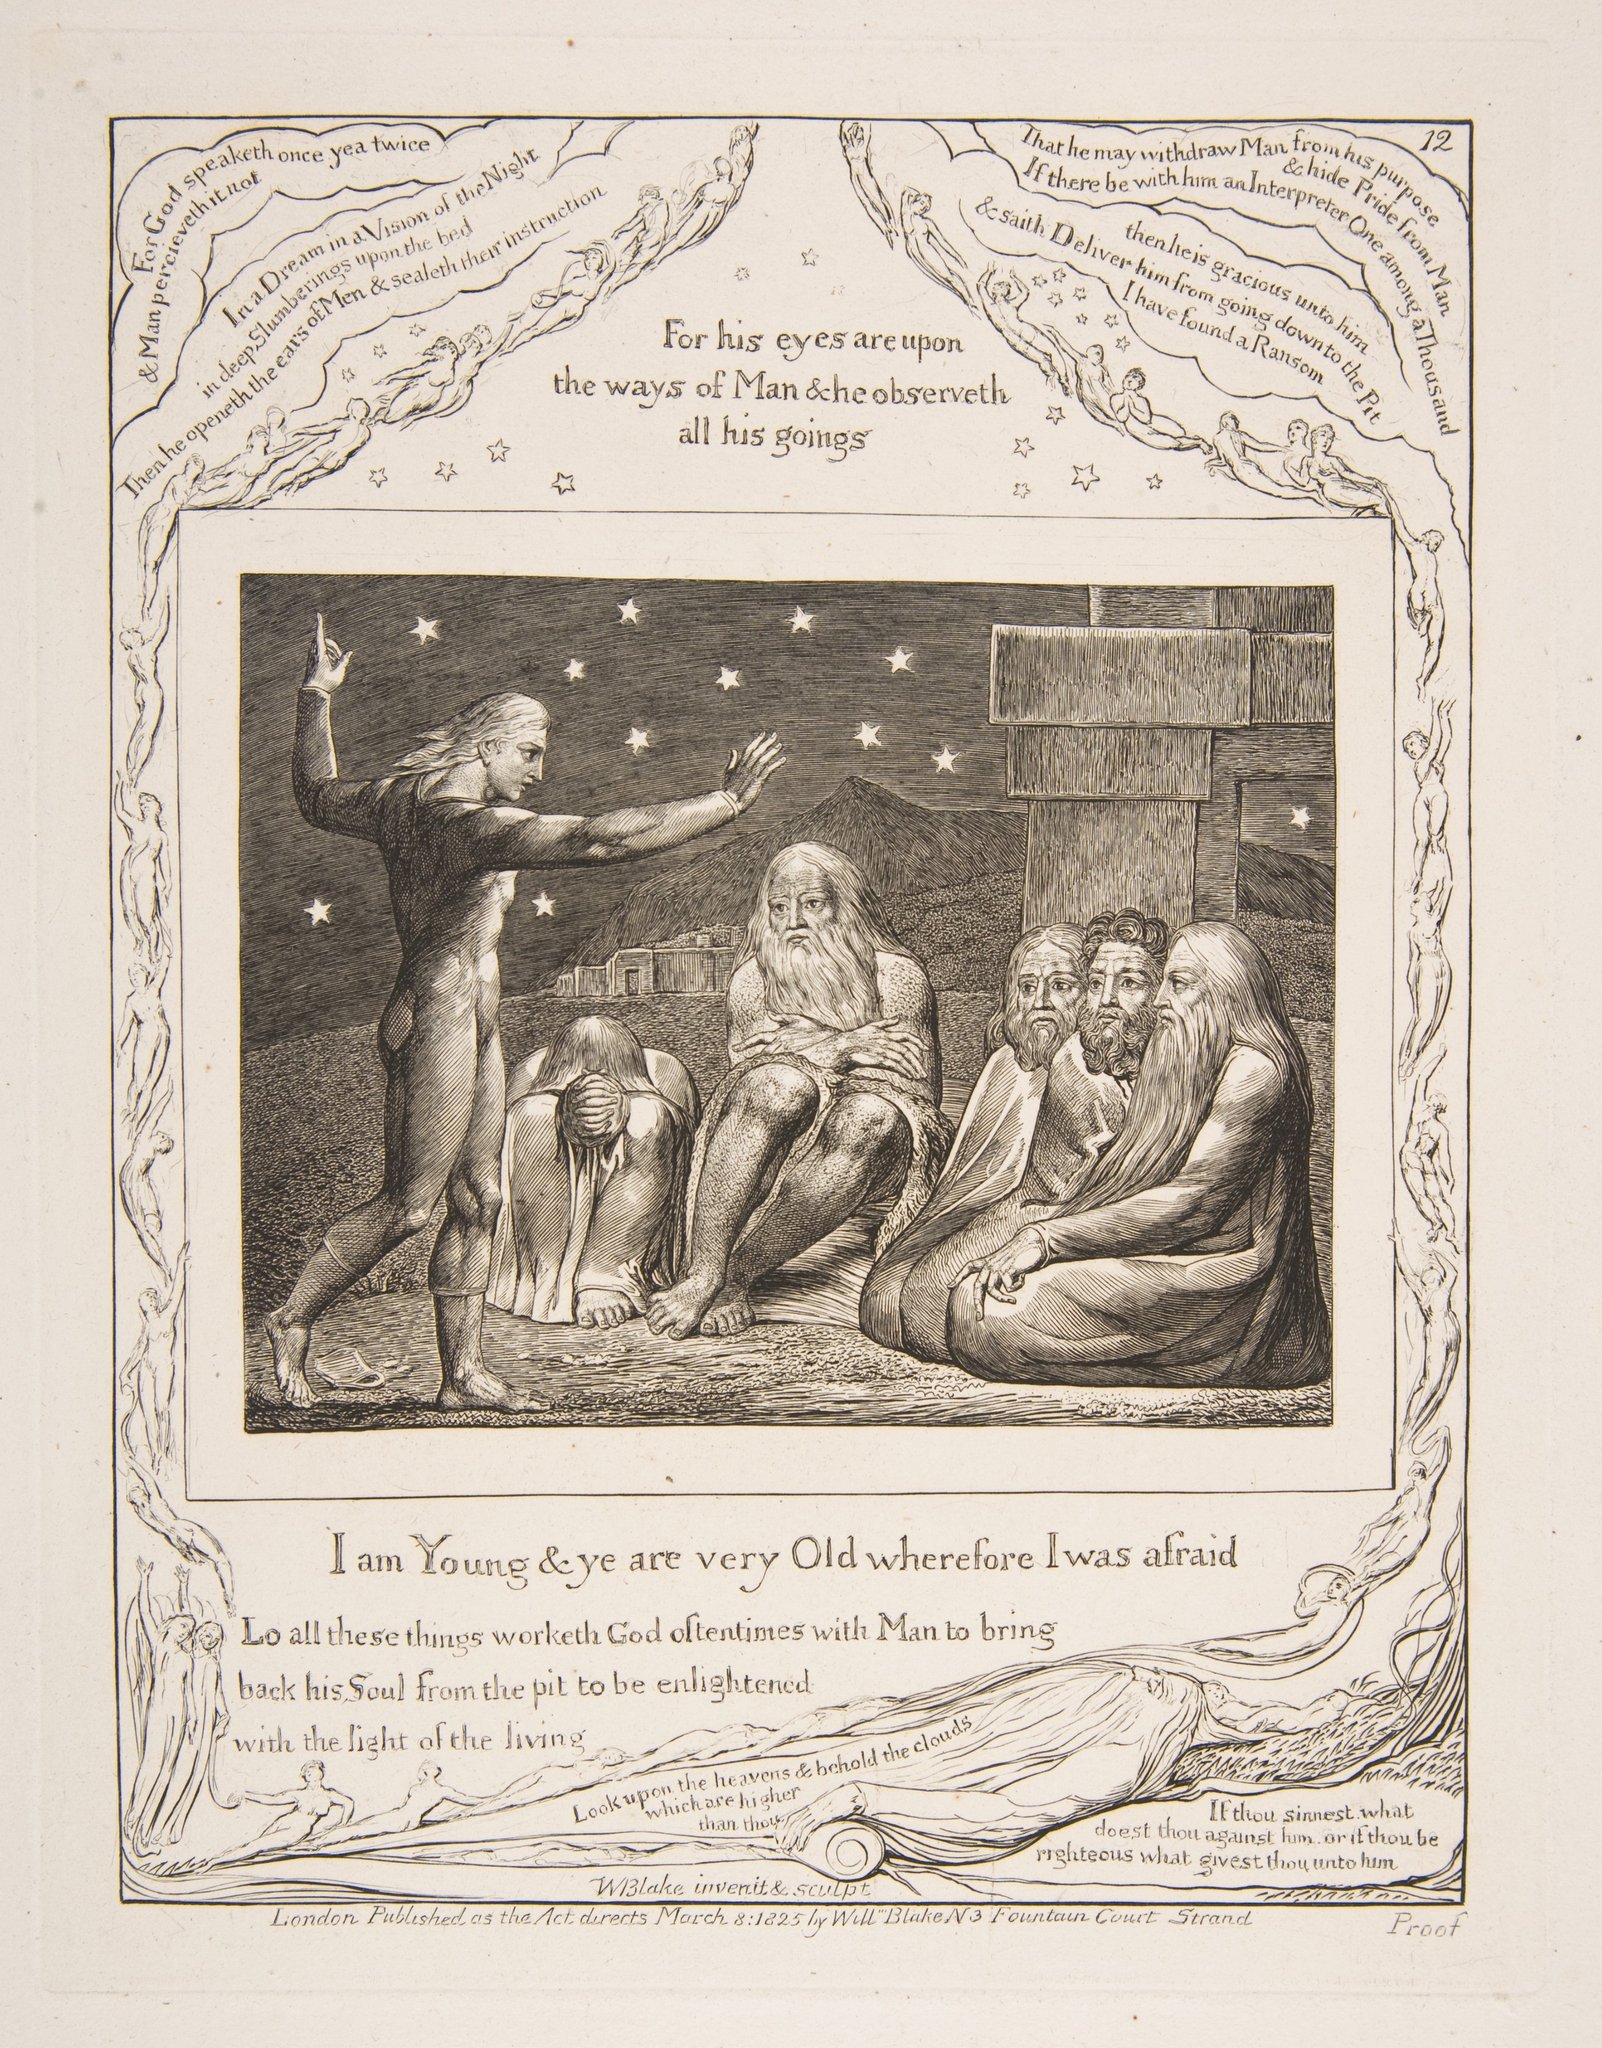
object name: print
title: The Wrath of Elihu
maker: william blake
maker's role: artist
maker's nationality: british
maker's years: 1757-1827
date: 1825-1826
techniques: engraving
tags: men,stars